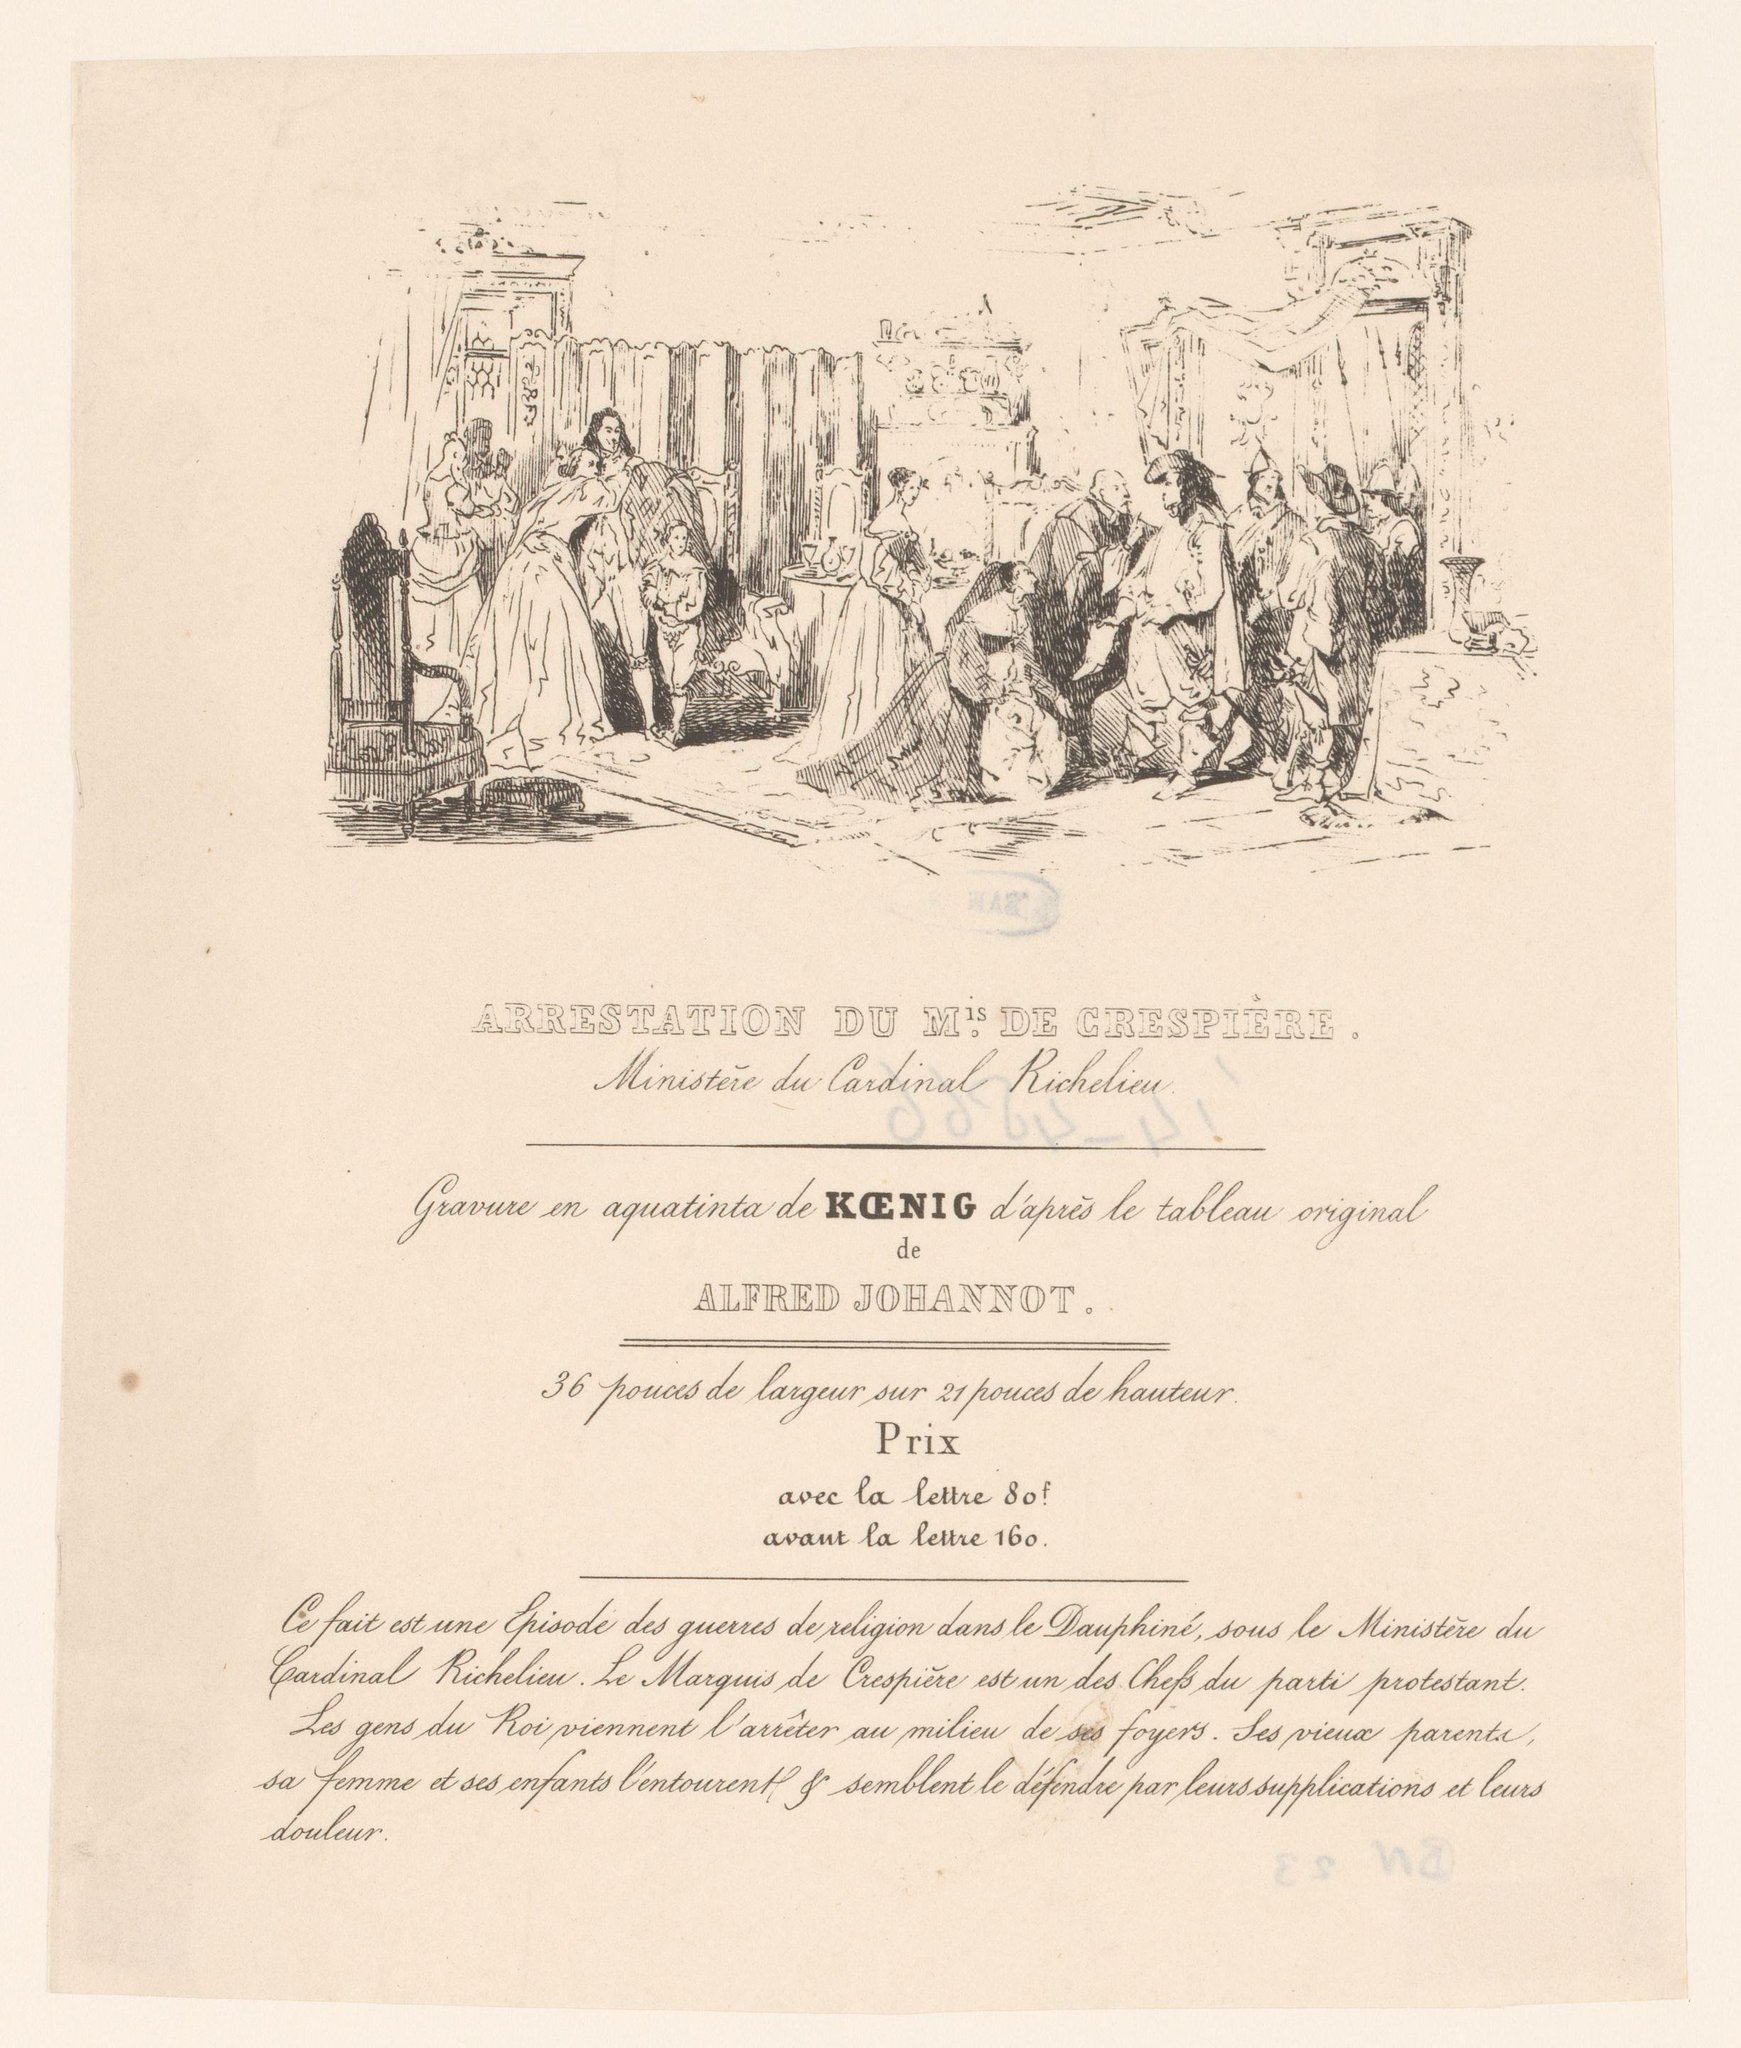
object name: print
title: Aankondiging van prent met arrestatie van mr. de Crespière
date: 1840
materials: paper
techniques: etching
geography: france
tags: arrest (of criminal)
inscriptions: collector's mark: Lugt 2228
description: Deze prent betreft een pagina uit een verkoopcatalogus van de prentmaker. Bovenaan is een schets van de prent die verkocht wordt aangebracht, onderaan zijn de prijzen met en zonder belettering en uitleg over de iconografie weergegeven.